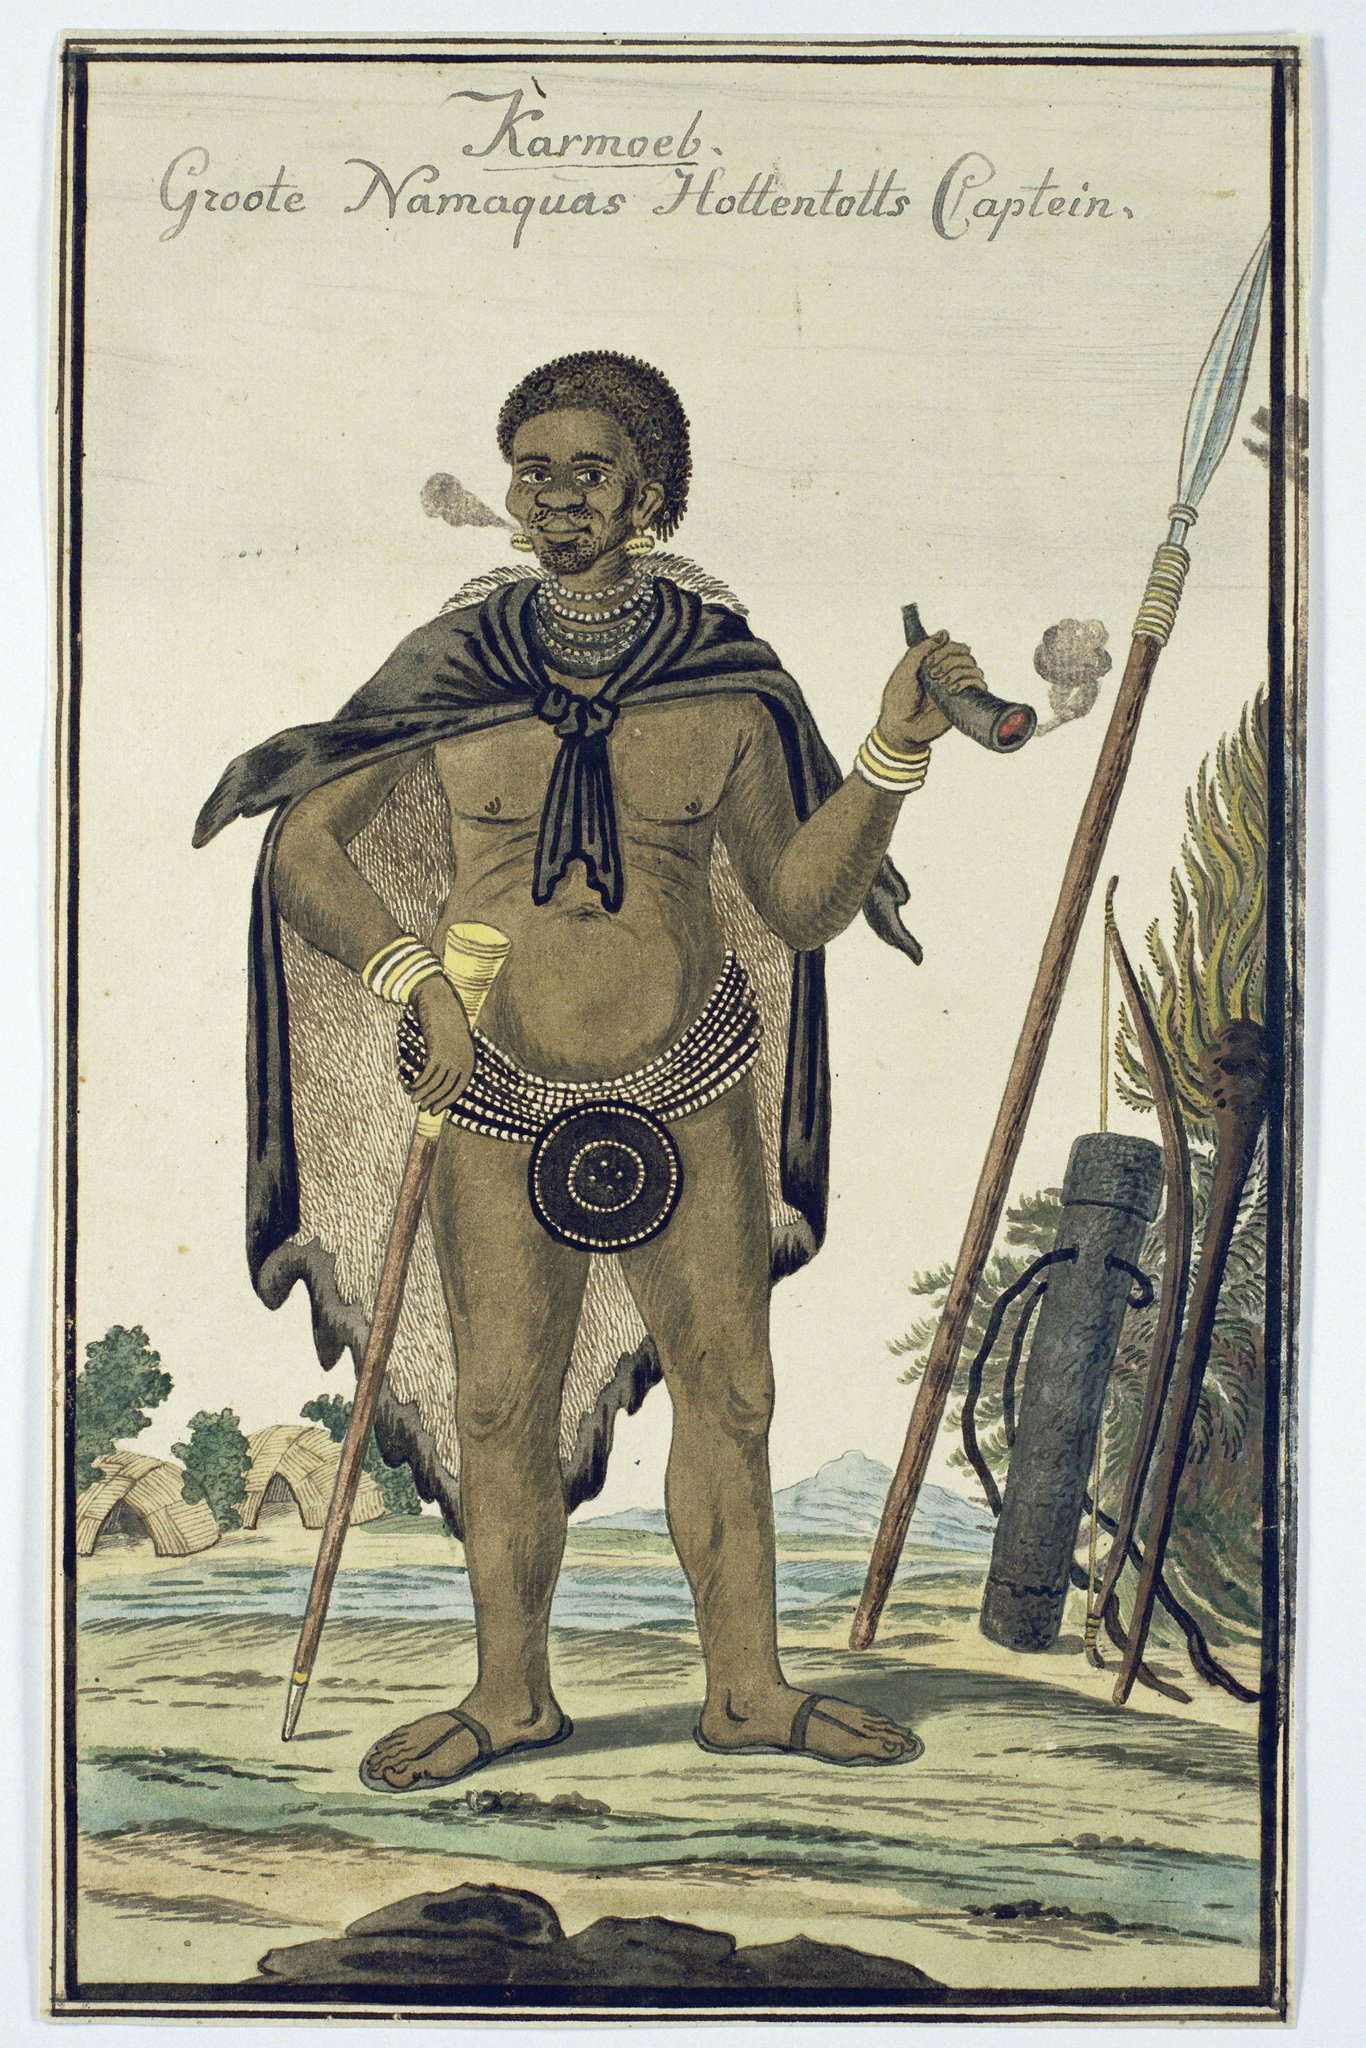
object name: drawing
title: Karmoeb, Captain of the Namaqua Khoisan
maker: robert jacob gordon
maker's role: draughtsman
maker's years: 1743-1795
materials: paint, ink, paper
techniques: brush, pen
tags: khoikhoi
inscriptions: annotation: ‘Karmoeb. (onderstreept) / Groote Namaquas Hottentotts Captein.’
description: De Khoi opperhoofden Karmoeb en Ruyter Twee Khoi opperhoofden met hun door de VOC geschonken waardigheidsstaf en ringkraag.